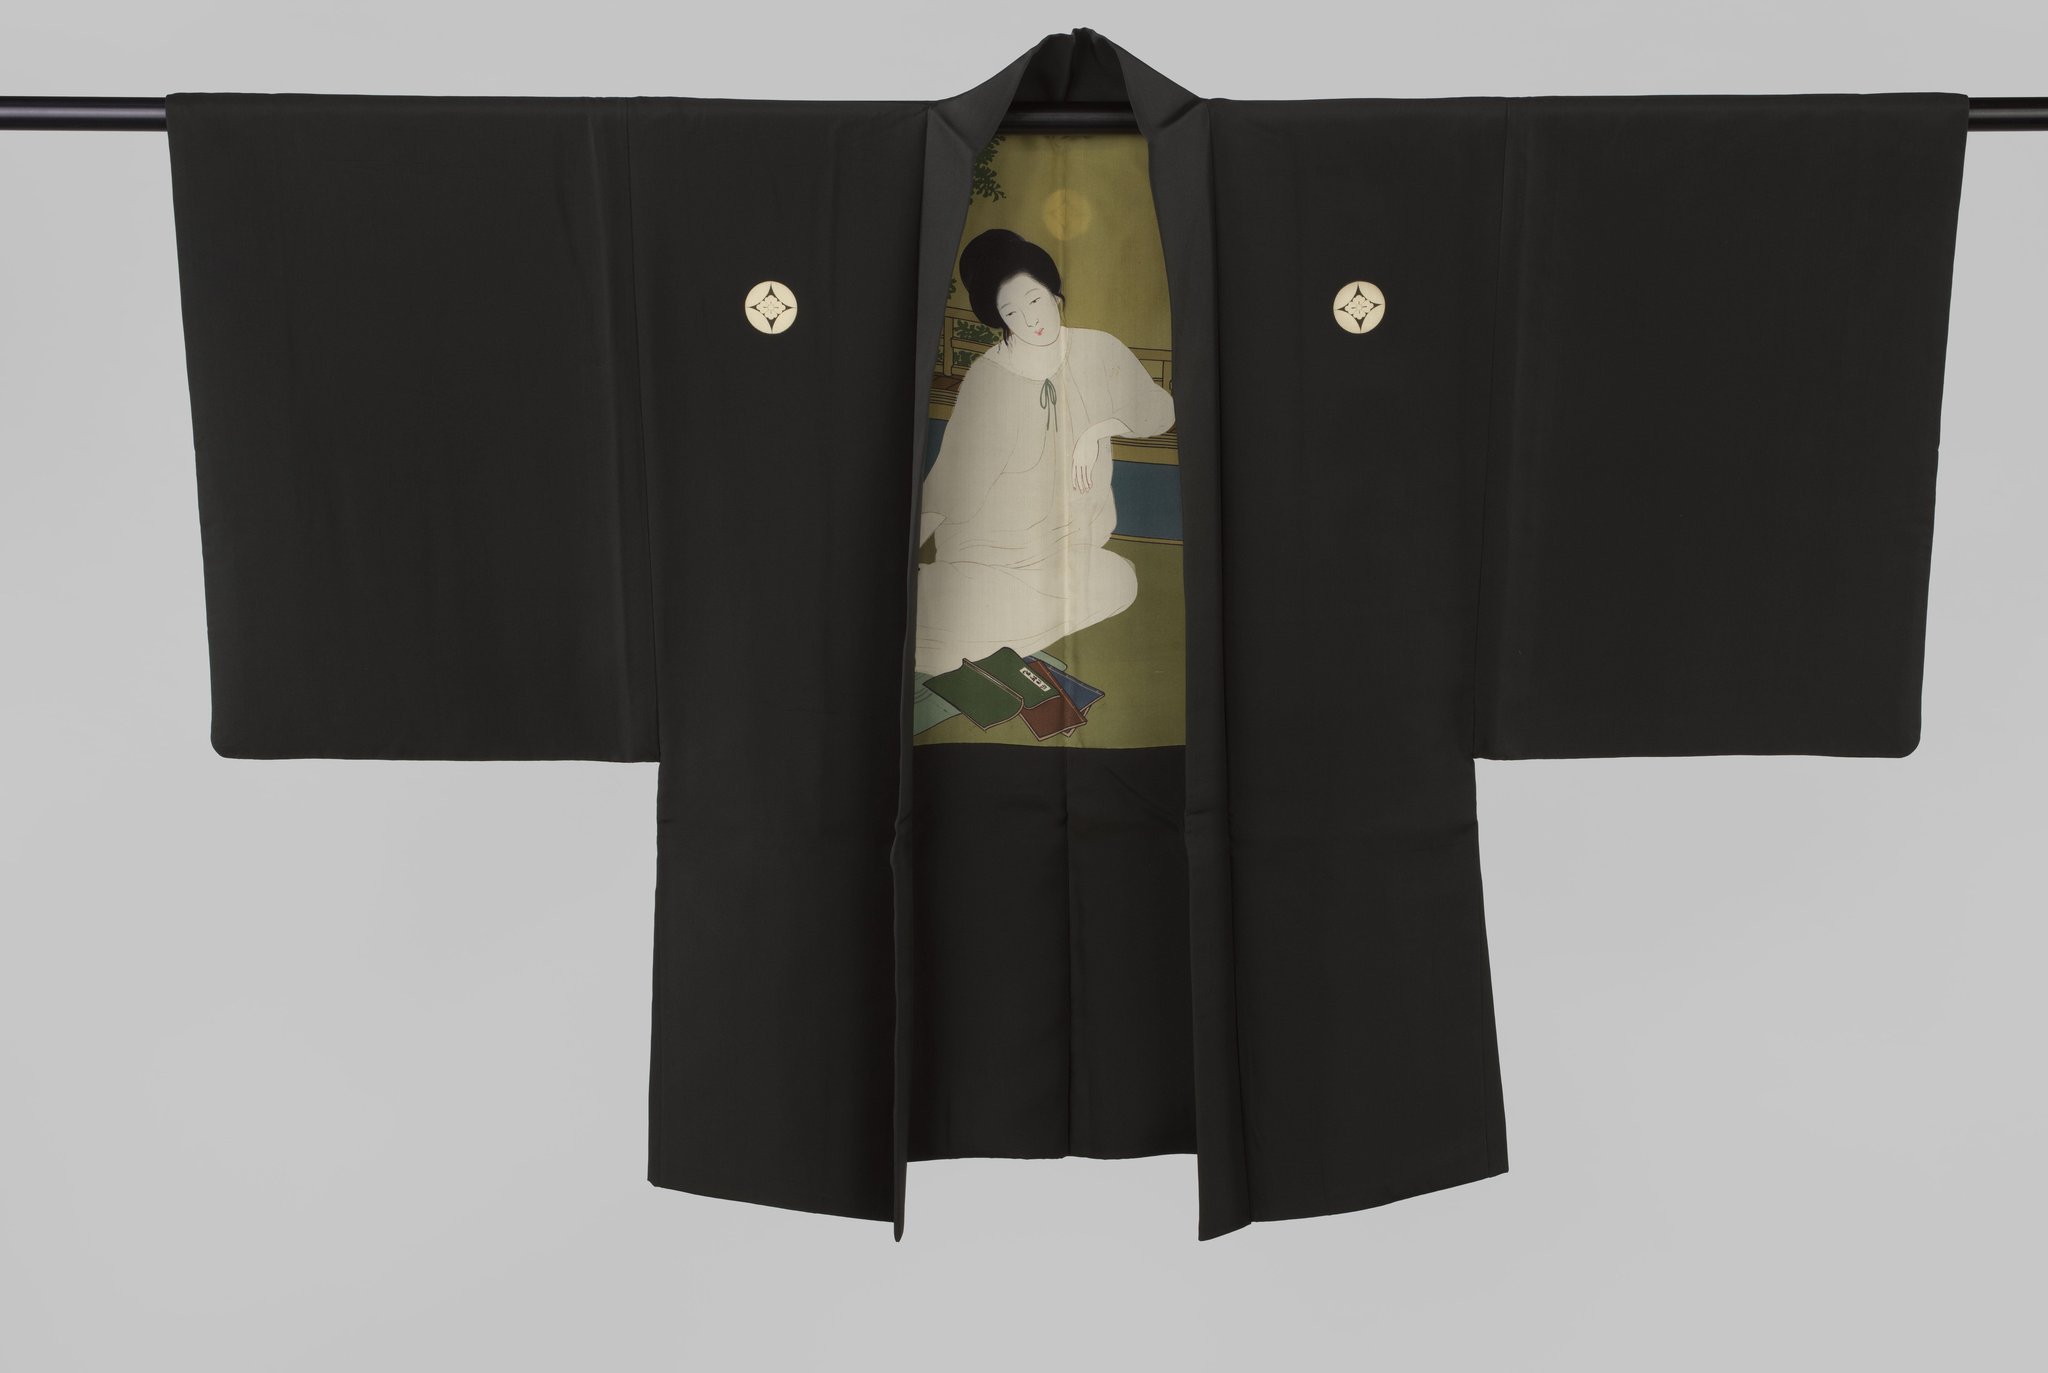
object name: kimono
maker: ito shoha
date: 1920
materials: silk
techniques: painting, weave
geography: japan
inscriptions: seal: ‘Shoha’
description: Kimonos: Mirrors of a Man’s Life. The kimonos on view here afford a glimpse into the lives of Japanese men from around the 1910s to the 1950s, from childhood to adulthood. This was a period of great change for Japan, marked by increasing industrialization and political conflicts culminating in the Second World War. Life modernized, technology advanced, and people took up new hobbies. Traditionally, men’s outer clothing tended to be reserved and a solid colour. Clothes could nevertheless also be a medium for highly unusual depictions which, however, were not visible to everyone. While motifs adorned the exterior of children’s garments, they were hidden from view in those worn by adult men. The decoration was found on the inside: on a long under garment, or the lining of a jacket (haori). This concealed imagery divulges the lives of the owners at the beginning of the 20th century. Childhood. A kimono marked events and stages in a man’s life. The kimonos on the top row (except the two everyday ones at either end) were worn by boys during the religious ceremony of miyamairi, namely an infant’s first visit to a Shinto shrine. This event followed a prescribed ritual and was an important and formative moment in the life of a Japanese man. Clothing for boys enveloped them in images that were to become part of their identity. The depictions included motifs that were considered gender and age appropriate: toys, manly hobbies, stories of heroic battles, technology, and so forth. Broader themes such as military conflicts and nationalism also filtered into children’s daily lives at an early stage. The textile designs of some kimonos combined traditional playthings with toy guns and tanks. Adulthood. What does a kimono tell about its owner and his life? Some men chose subjects from classical culture, such as No or Kabuki theatre, while others preferred themes from contemporary life, such as gramophone records or the new popular sport of baseball. Thus, these garments were a canvas for personal choices, but also for political propaganda and nationalistic messages. Some representations are eccentric or even erotic. Others are more general and linked to political events. All aspects of a man’s inner life are touched on. Portraits of beautiful women and playful dogs contrast with images of war, celebrating victories in China. As these representations were under the outer garments, they remained hidden from the outside world and were thus seen only by the kimono’s owner and his intimates.